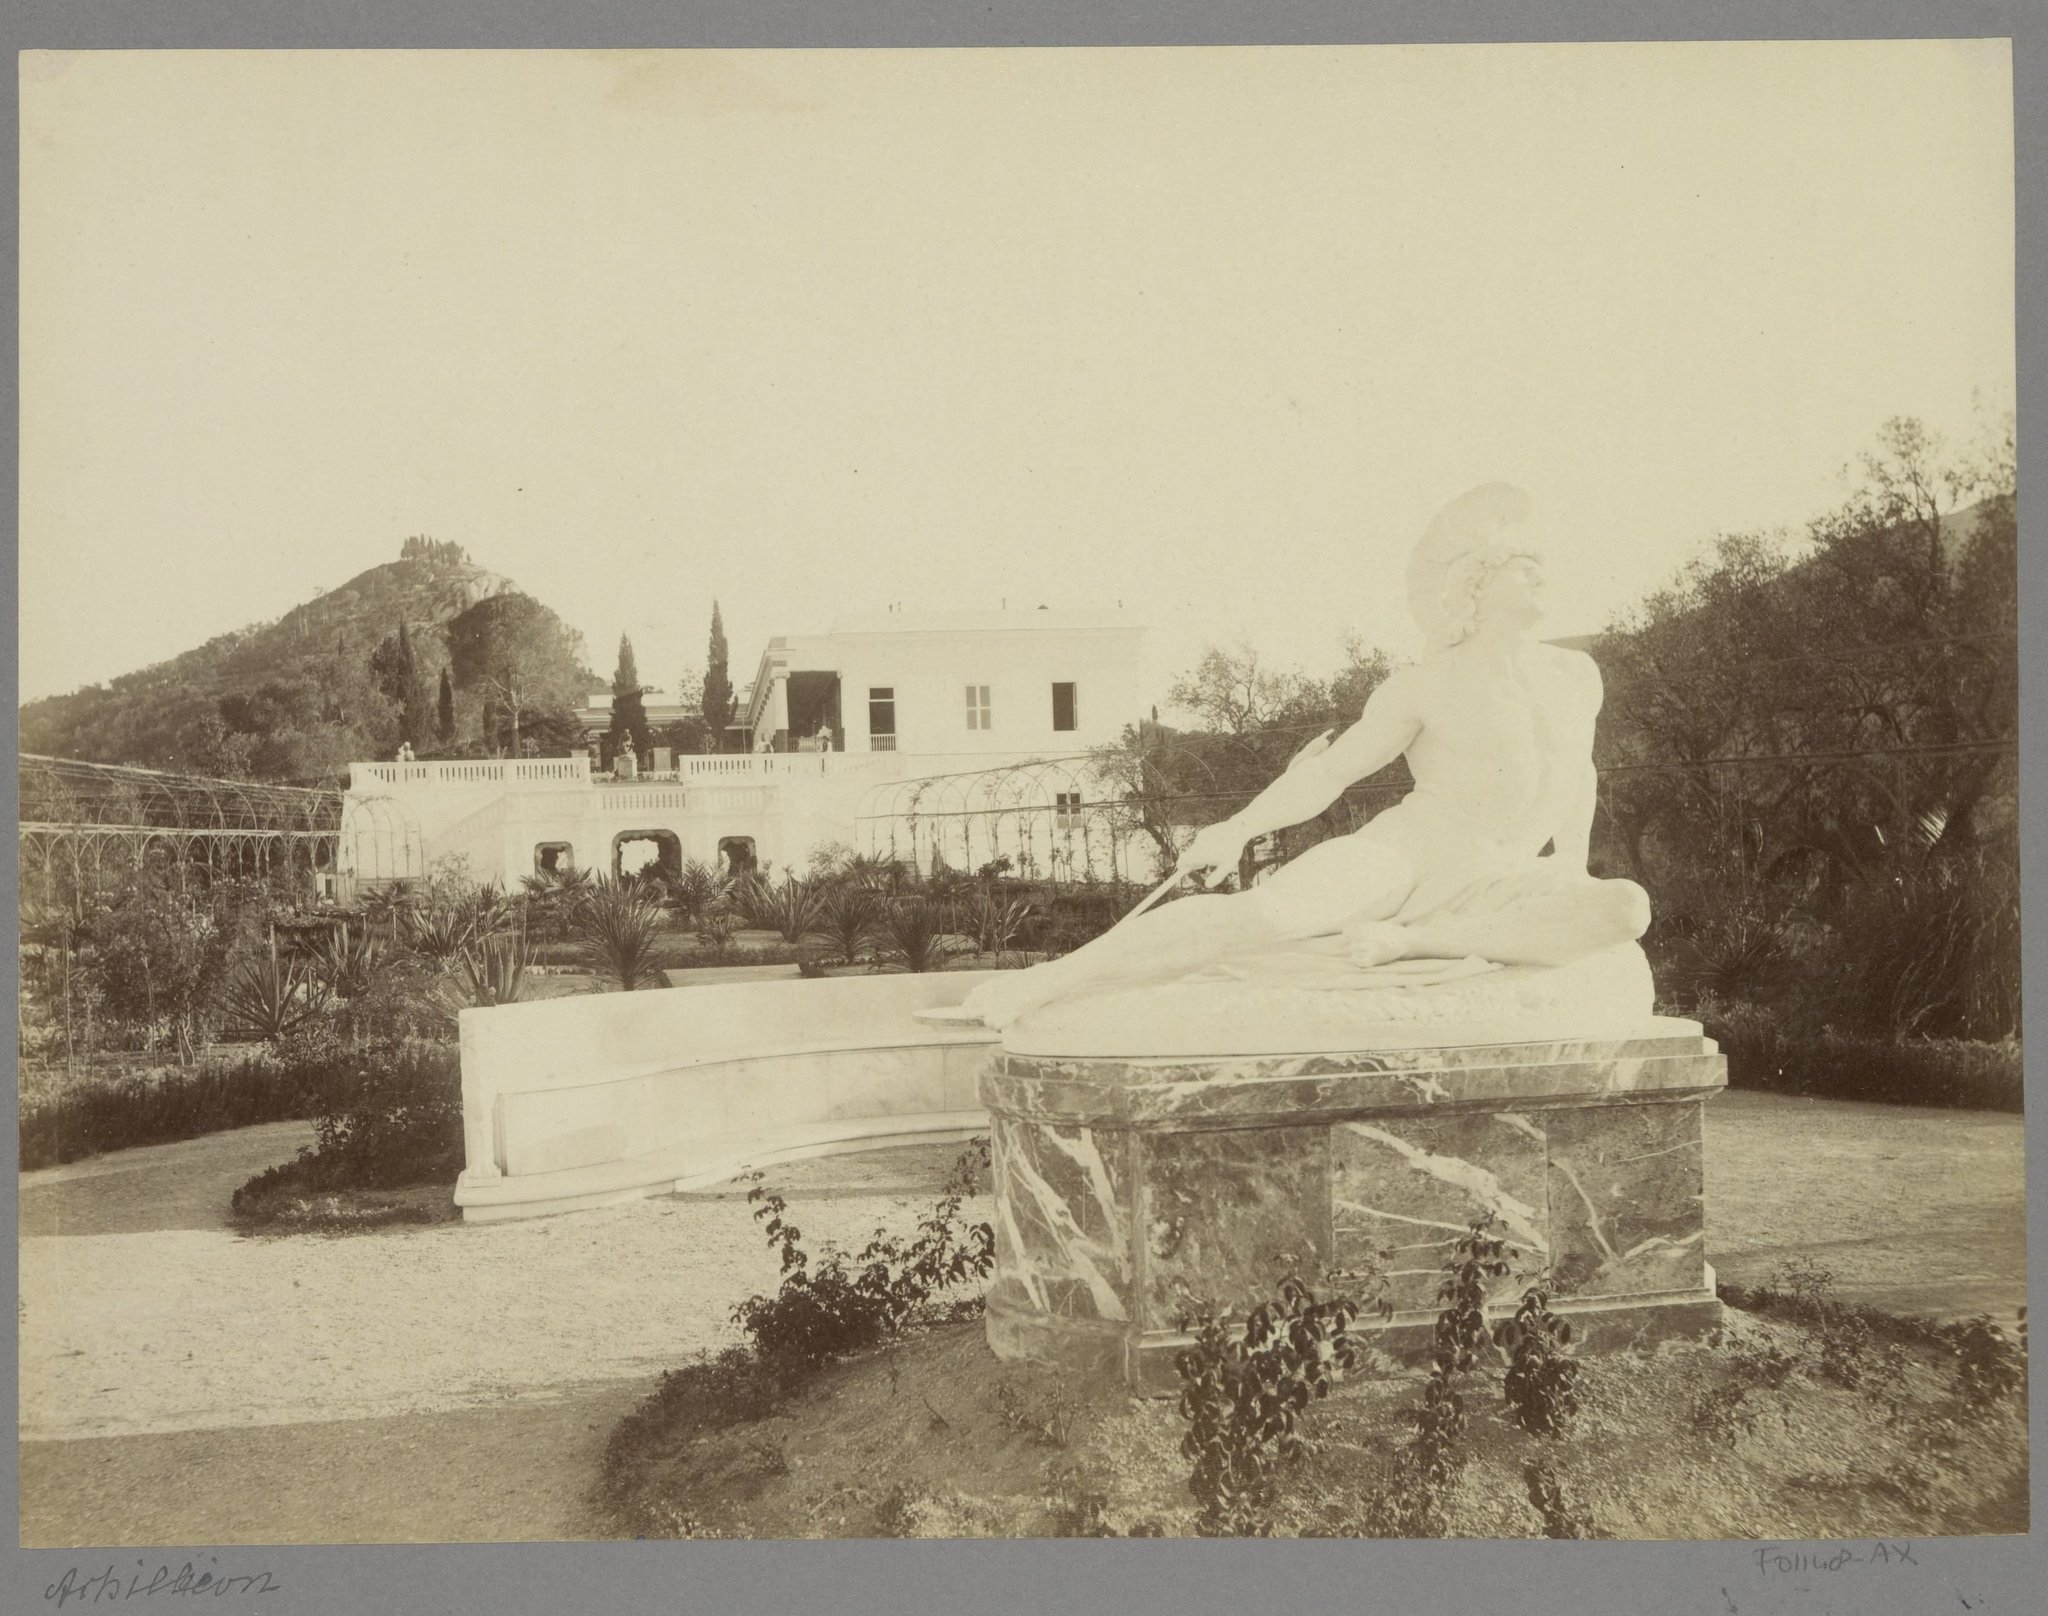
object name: photograph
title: Beeld van Achilles bij het Achilleion op Corfu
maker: Anonymous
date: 1895-1905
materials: paper, photographic support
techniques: albumen print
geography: corfu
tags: piece of sculpture, reproduction of a piece of sculpture, villa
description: Onderdeel van Reisalbum met foto's van bezienswaardigheden in Griekenland en Egypte.